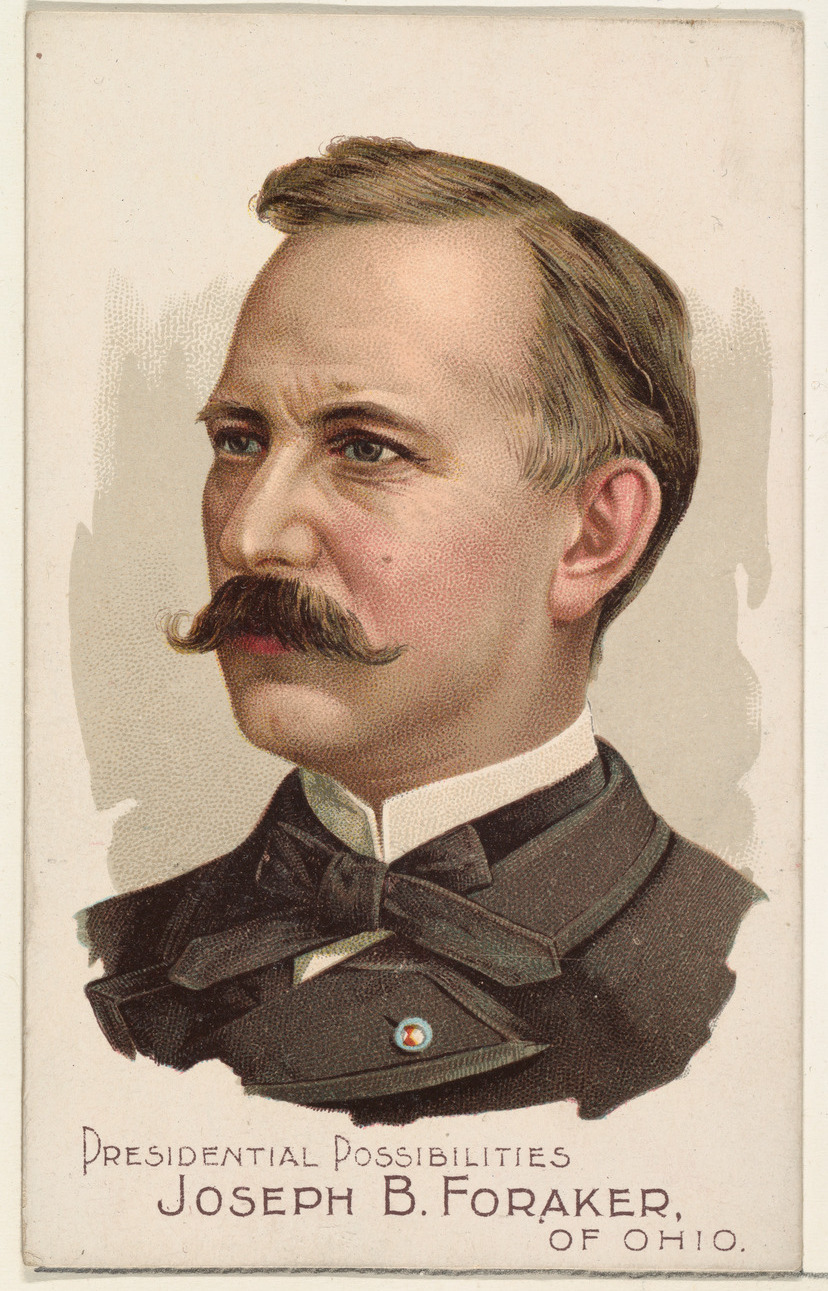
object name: print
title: Joseph B. Foraker of Ohio, from the Presidential Possibilities series (N124) issued by Duke Sons & Co. to promote Honest Long Cut Tobacco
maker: w. duke, sons & co.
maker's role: publisher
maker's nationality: american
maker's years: 1870-1920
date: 1888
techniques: color lithograph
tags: men,portraits